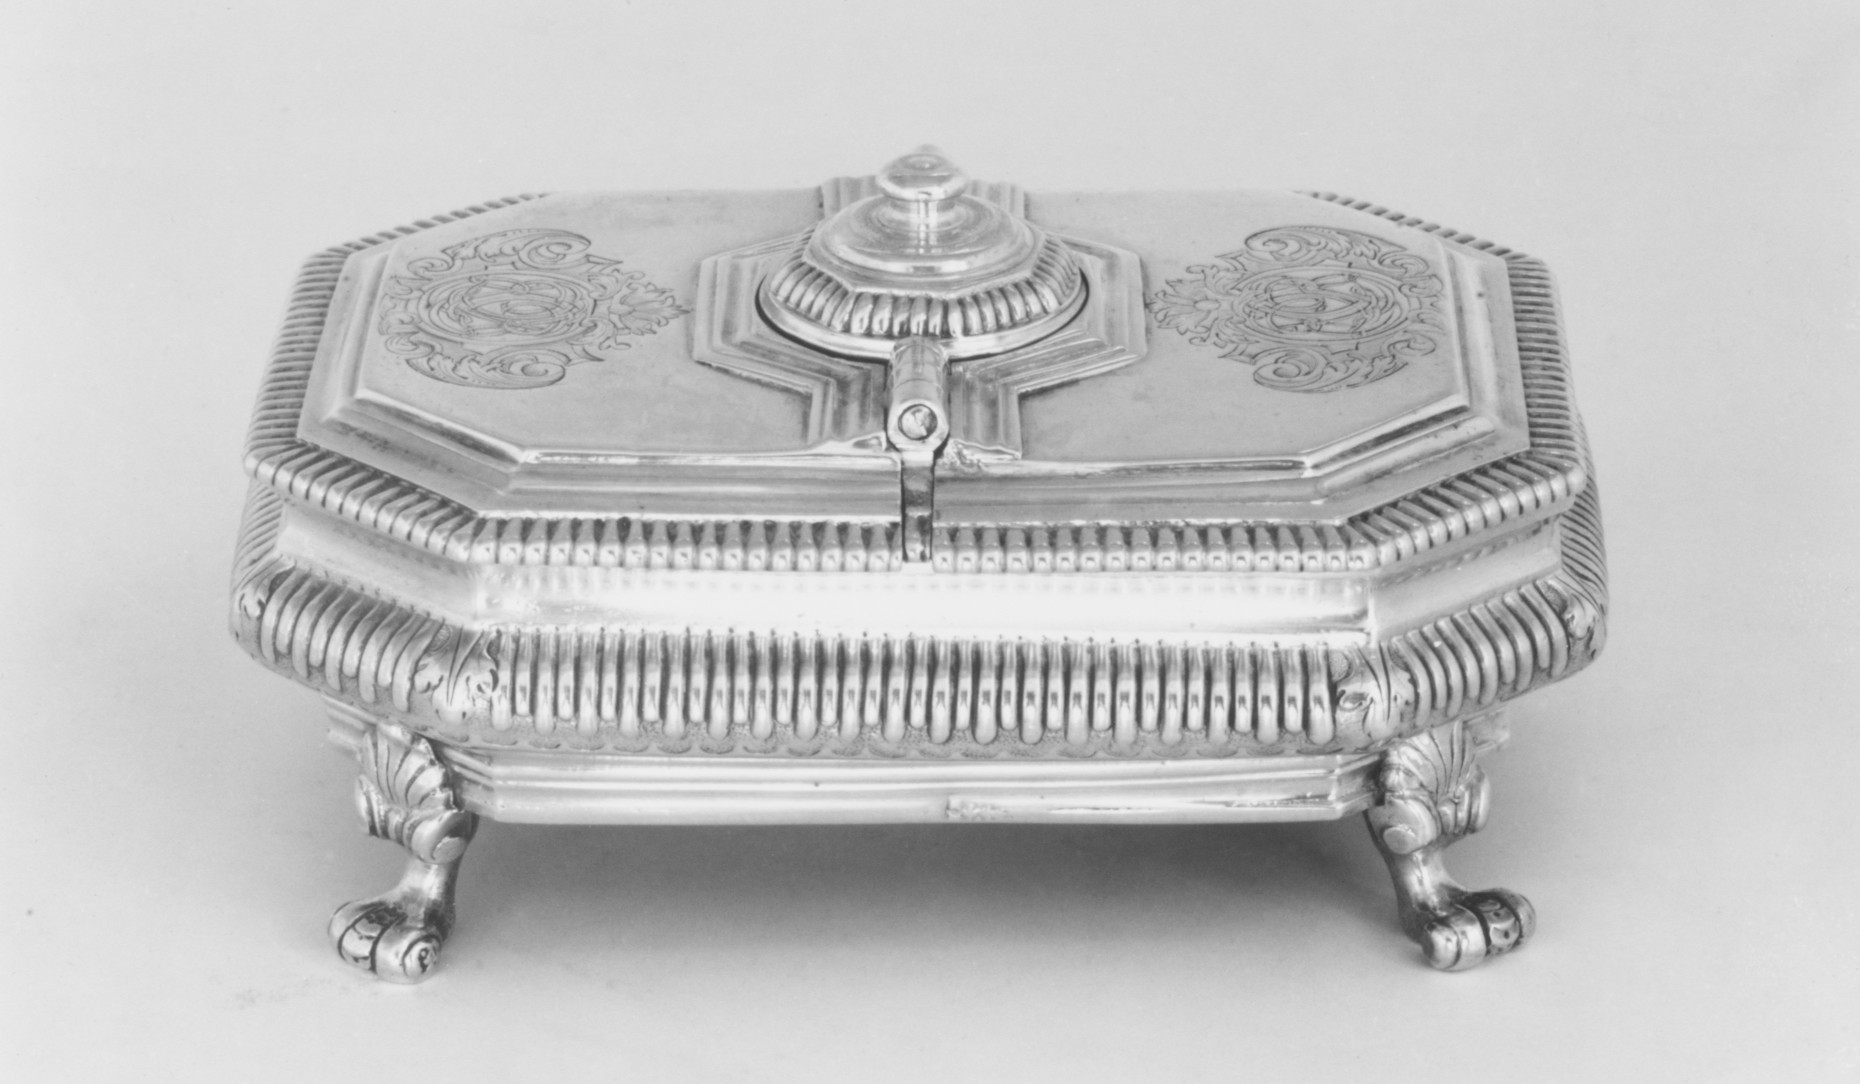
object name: spice box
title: Spice box with grater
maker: nicolas mahon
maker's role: maker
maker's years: 1633-1733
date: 1723-1724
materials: silver